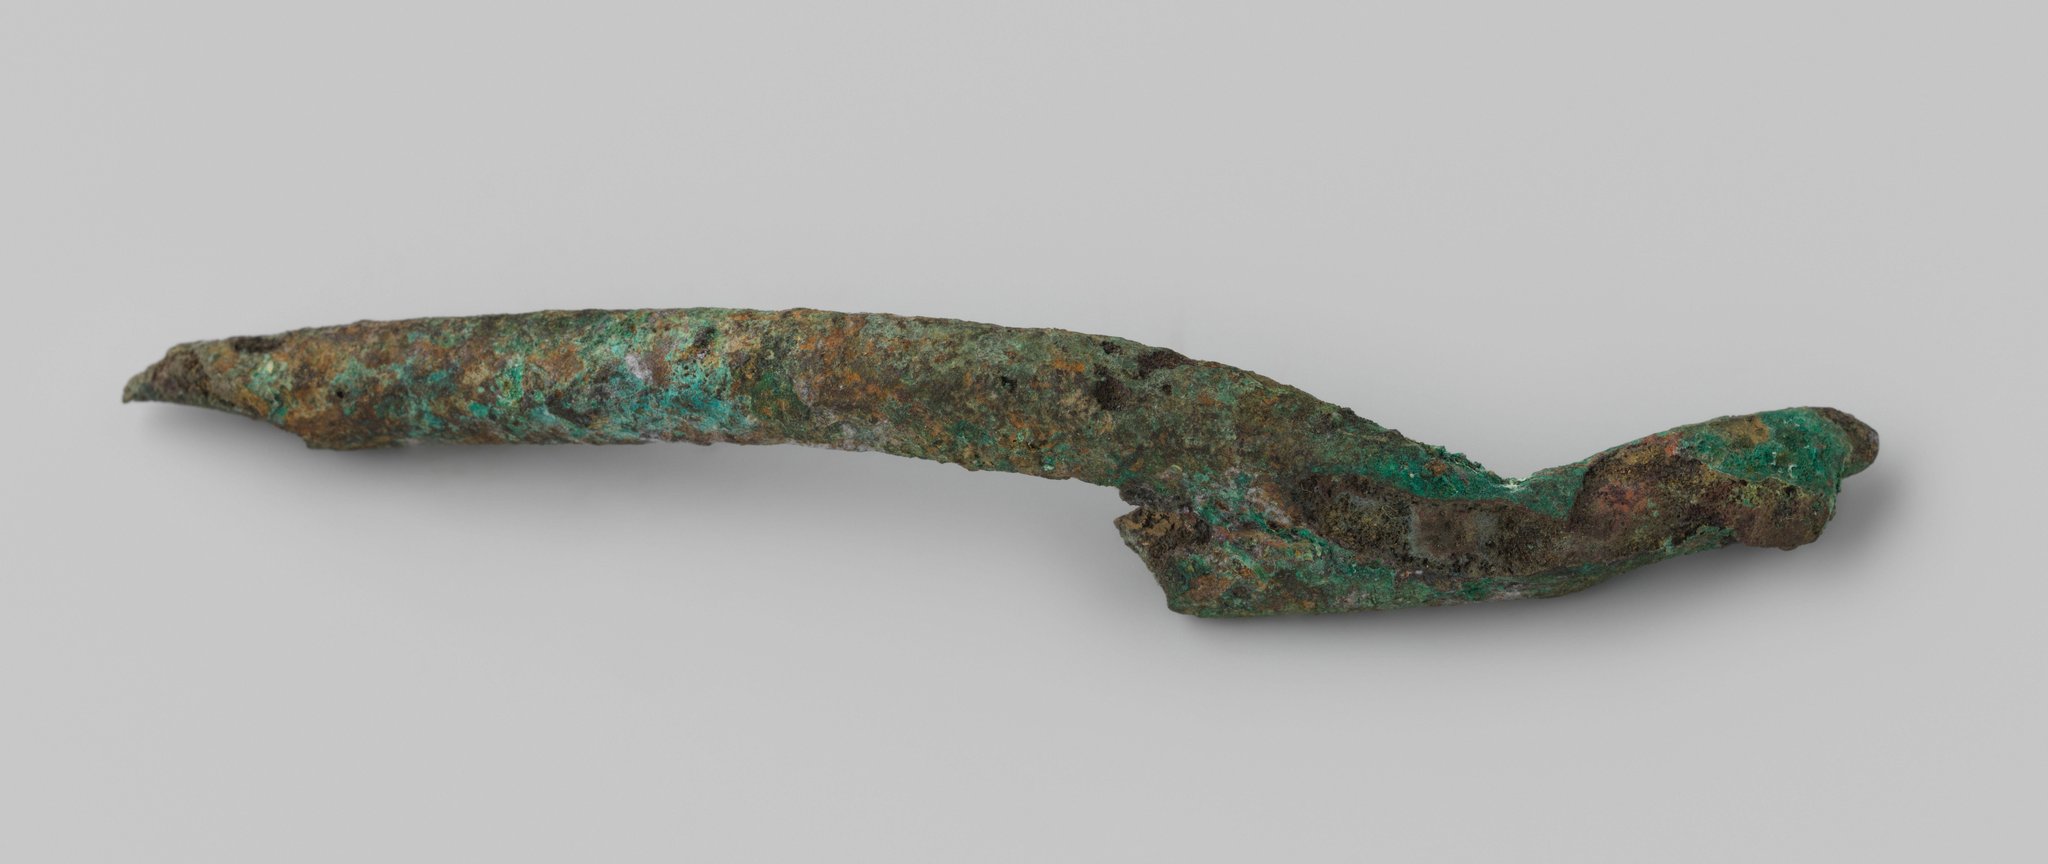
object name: part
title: Fragment of onderdeel uit het wrak van de Oost-Indiëvaarder Hollandia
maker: Anonymous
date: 1743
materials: copper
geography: netherlands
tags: verenigde oostindische compagnie, hollandia (schip), annet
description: Varied parts or fragments, bar(-shaped) fragments; fragm, extremely eroded, one end broken, square in section, other end slightly curved, joining a 2nd bar fragm, paralleled, smaller in section.